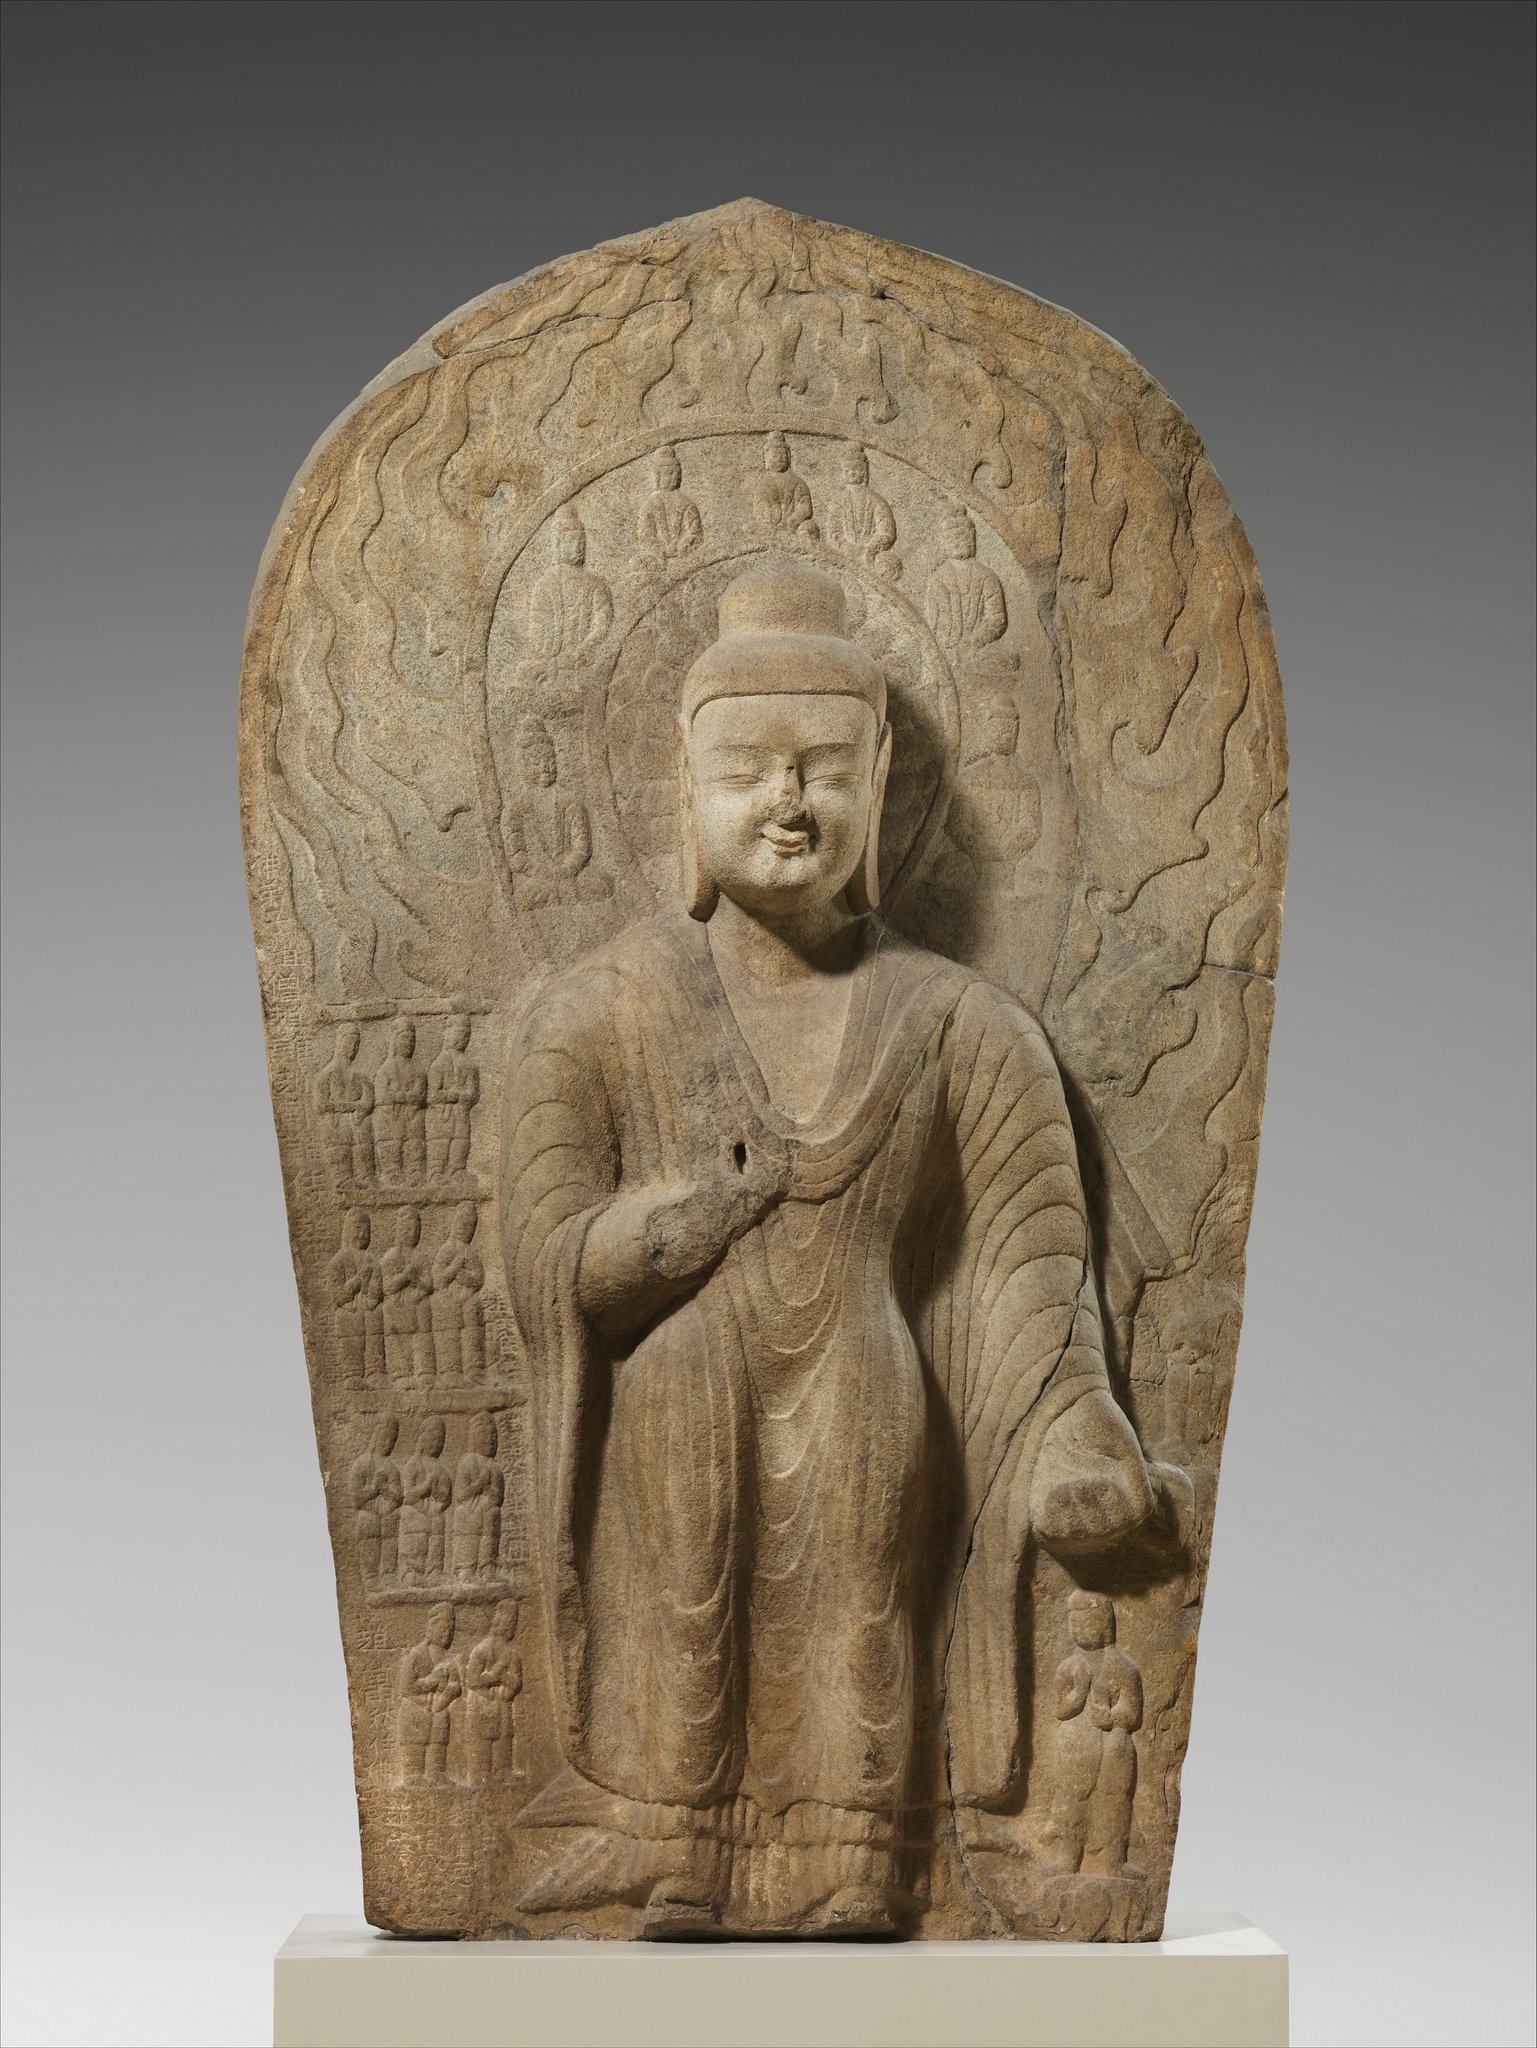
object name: stele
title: Buddha Dipankara (Randengfo)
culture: chinese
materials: stone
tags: buddhism,buddha